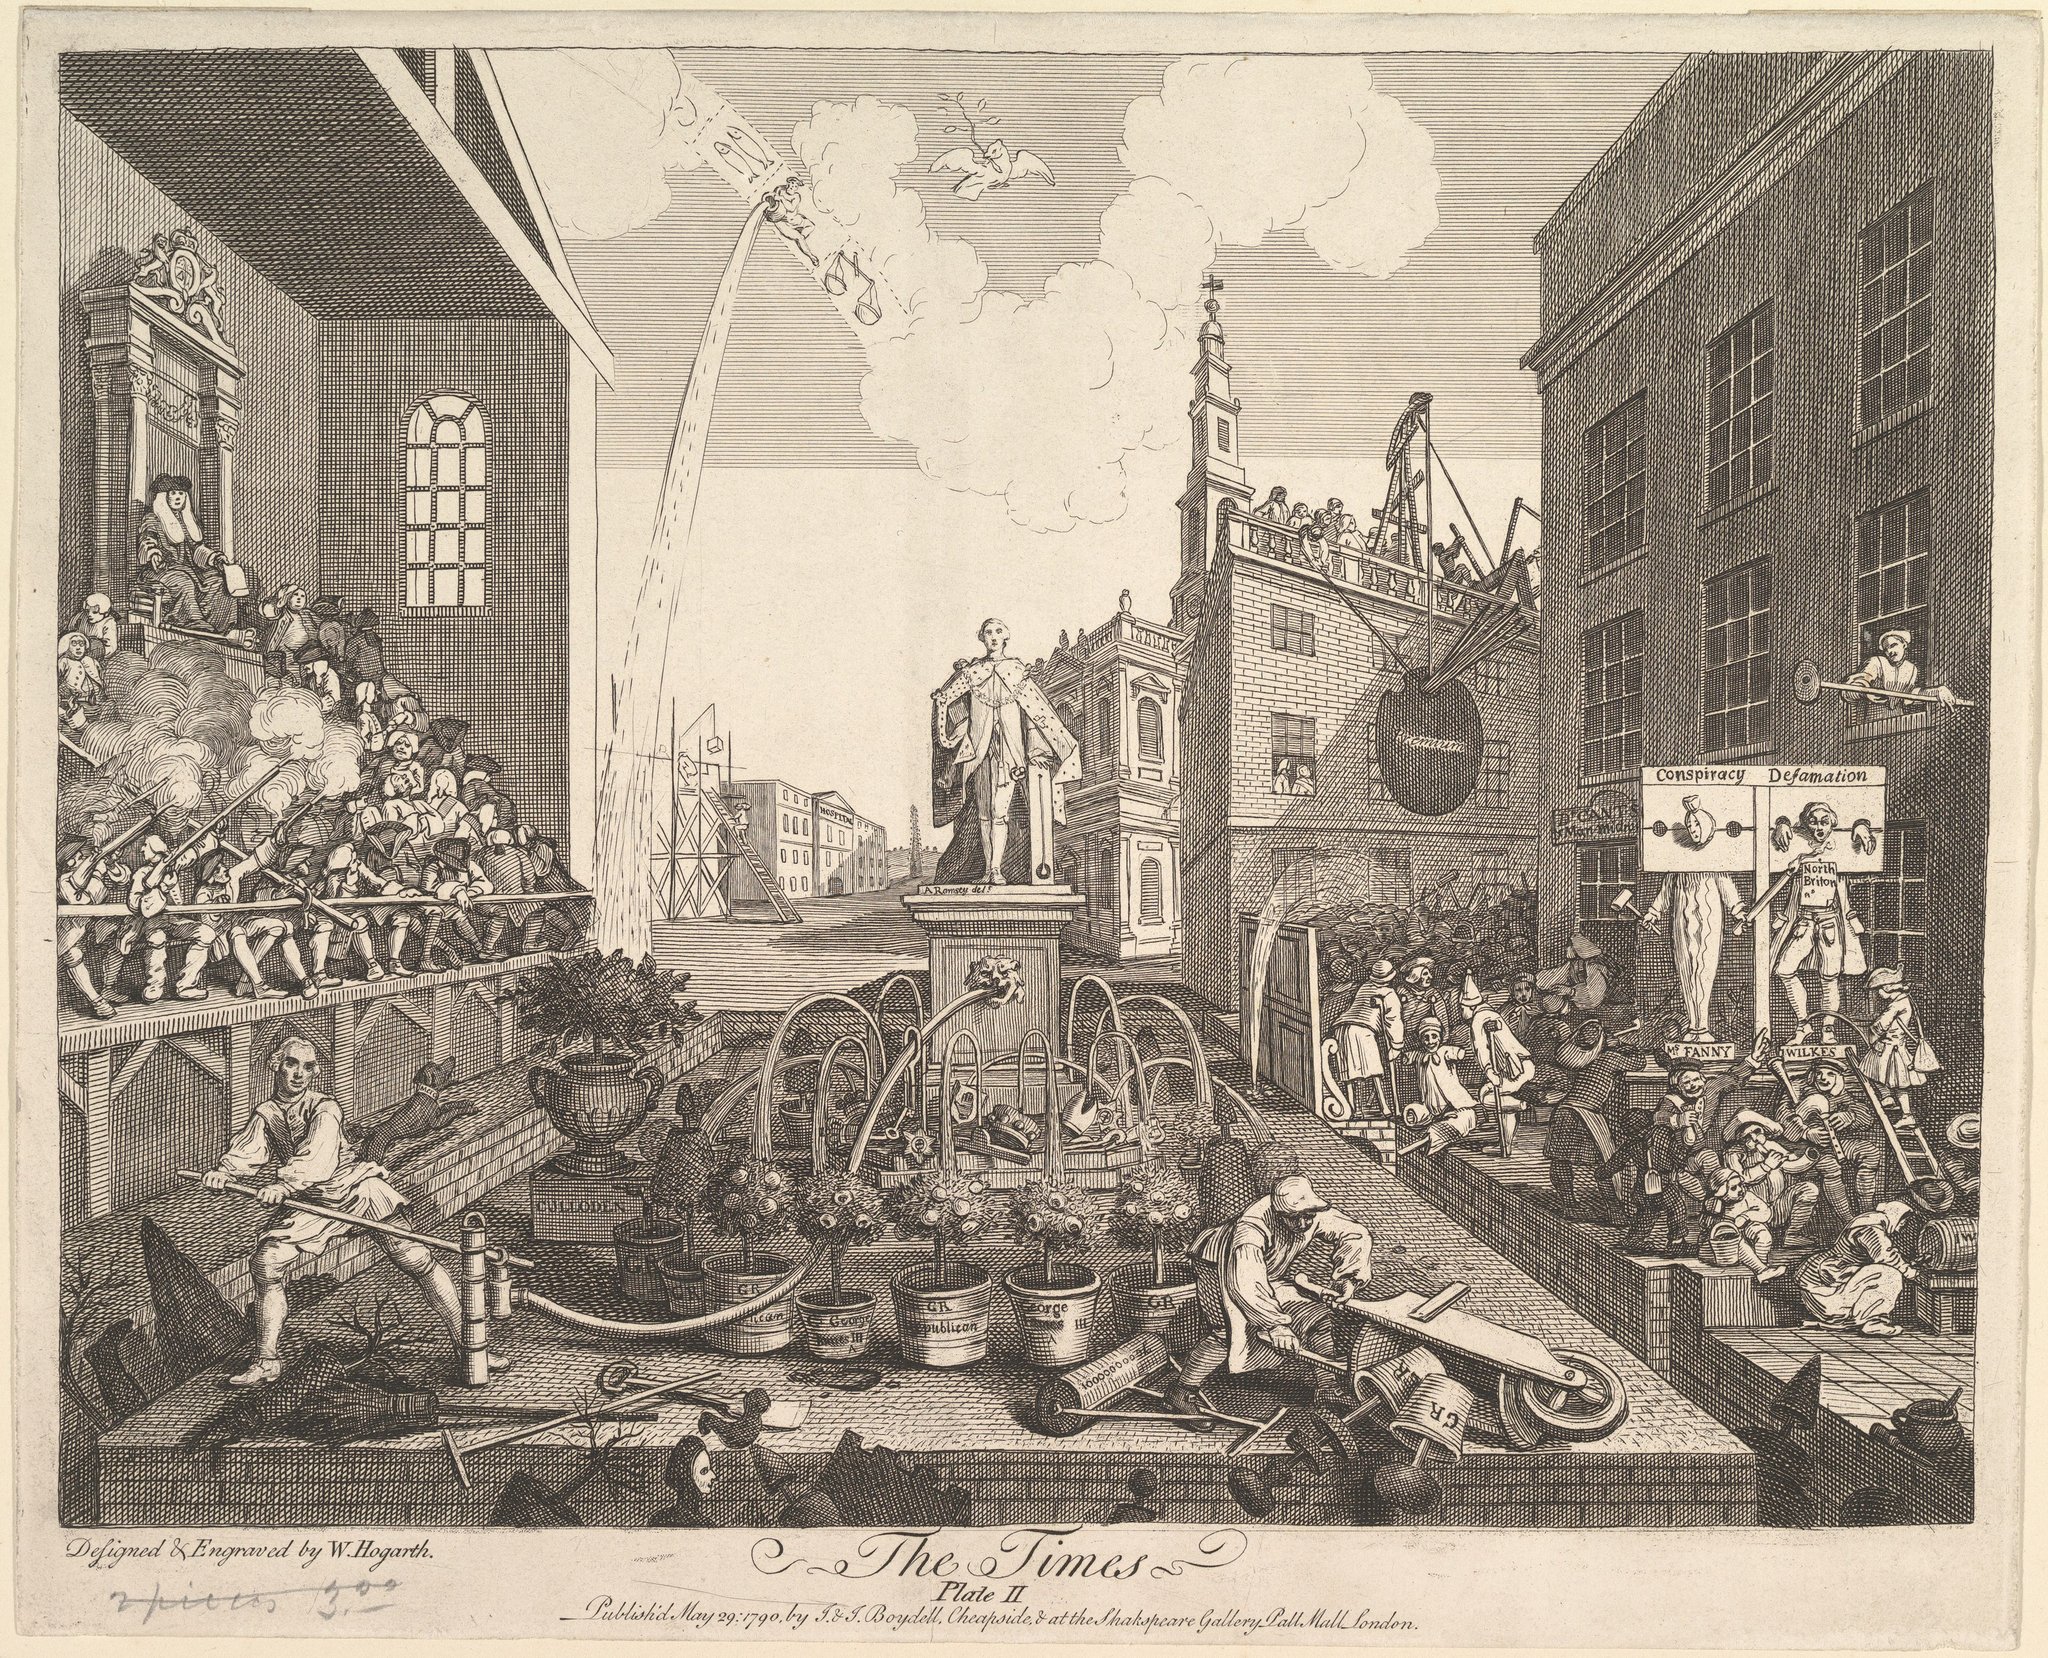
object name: print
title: The Times, Plate 2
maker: william hogarth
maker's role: artist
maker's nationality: british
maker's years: 1697-1764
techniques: engraving, etching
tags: satire,buildings,fountains,men,london